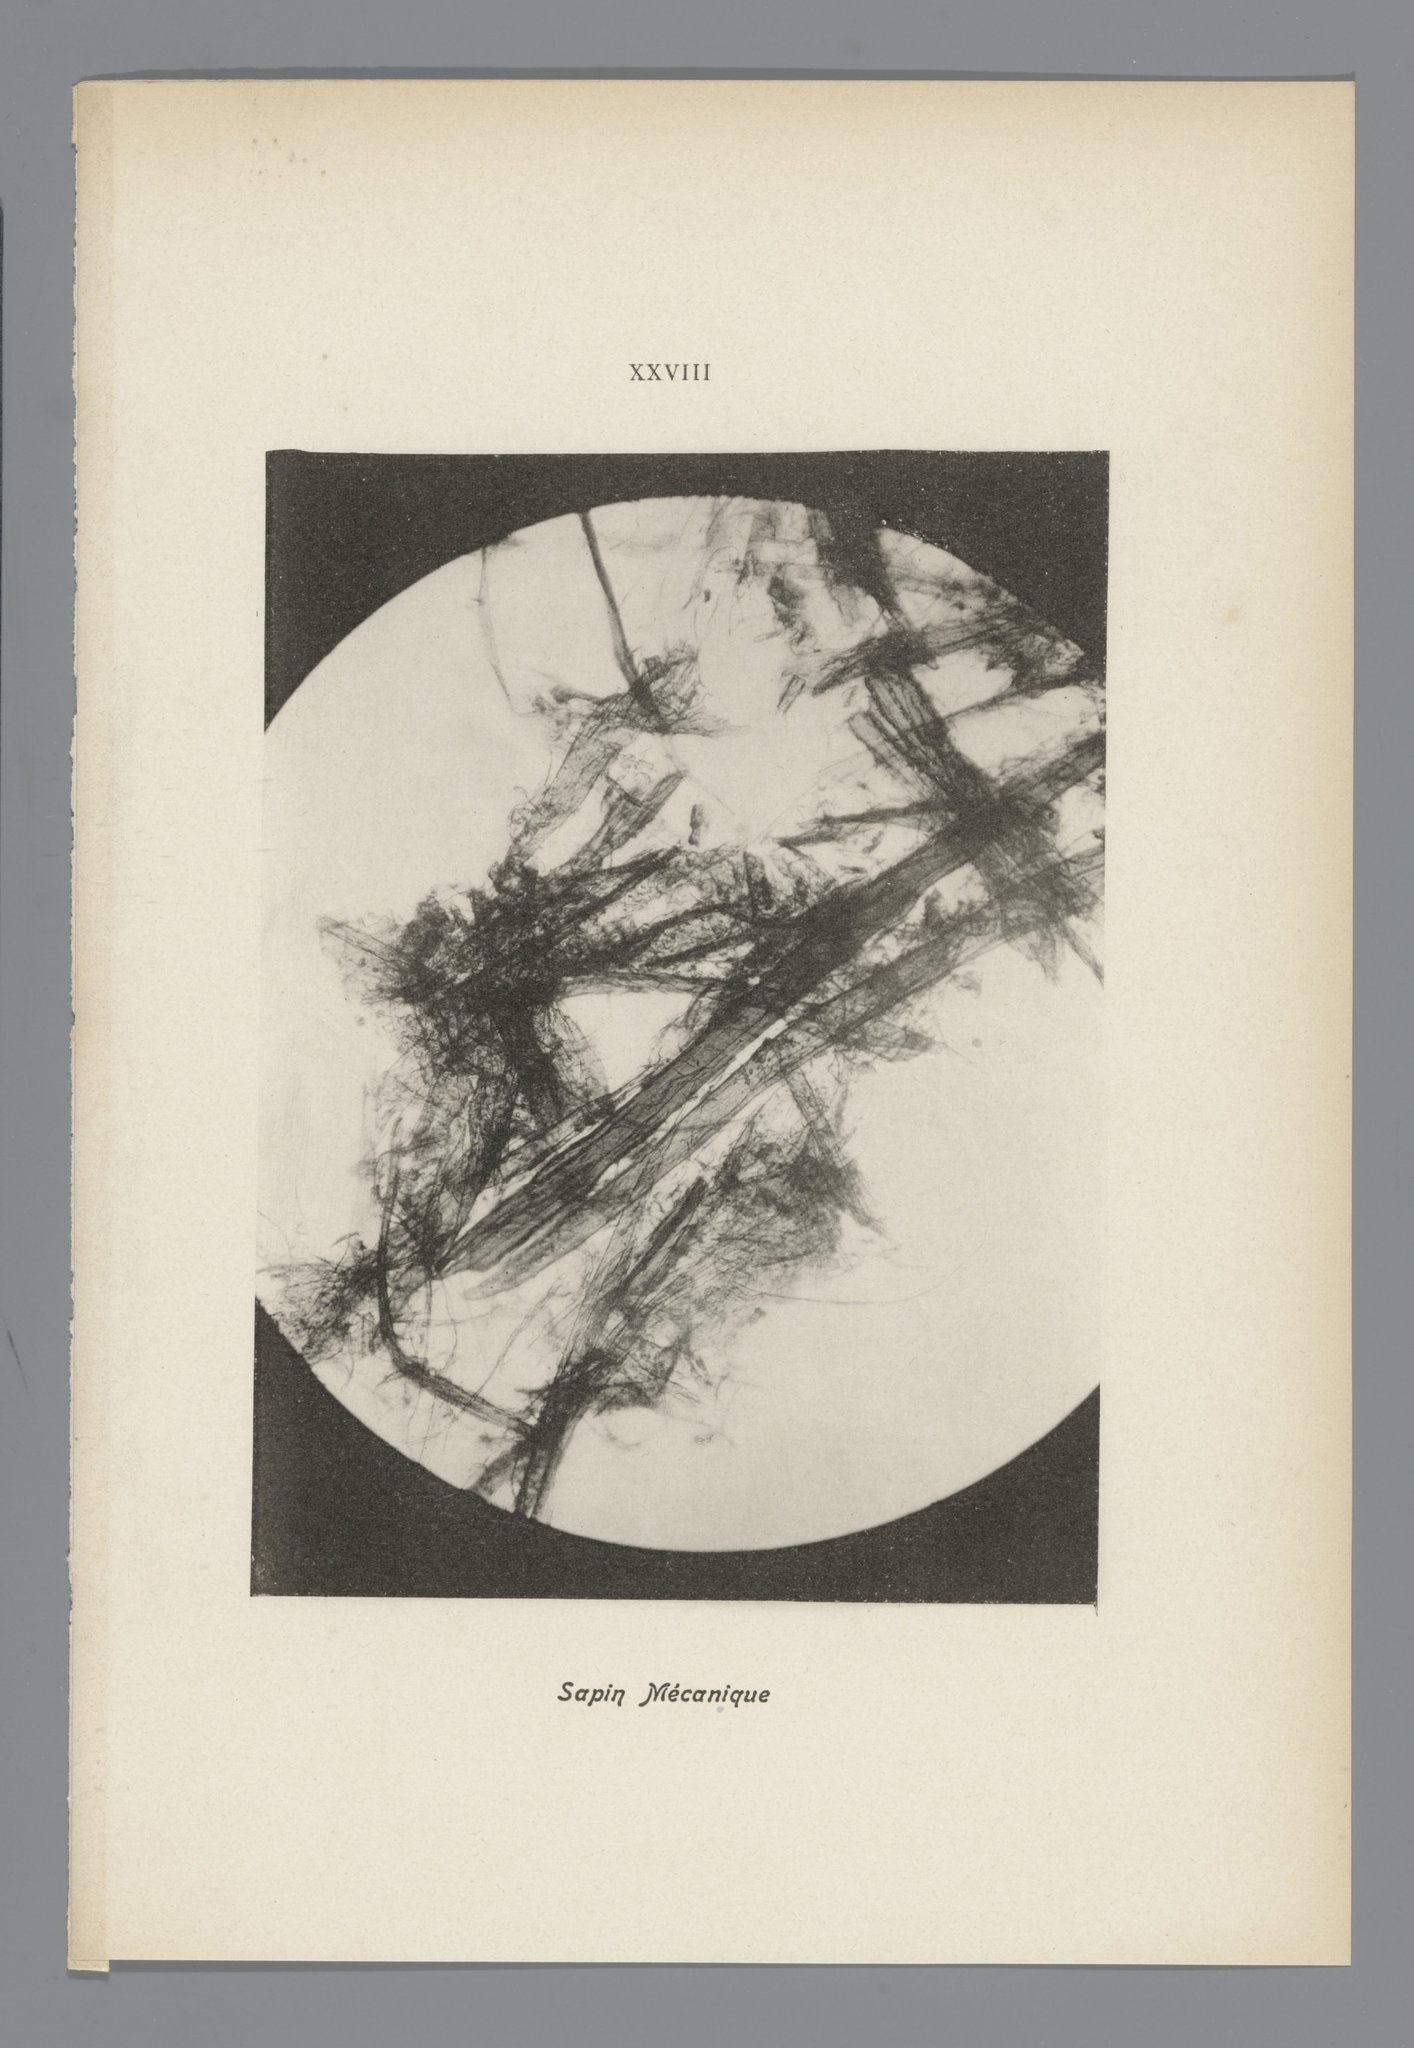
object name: photograph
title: Photomicrographs of Paper Fibres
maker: Anonymous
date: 1900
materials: ink, paper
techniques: photograph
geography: france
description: For science, photography was a useful tool for supplementing or refuting what could be observed with the human eye. The camera, after all, saw more than the eye, and the photographic plate had a better ‘memory’ than man. By combining a microscope and a camera, tiny objects could also be studied closely.